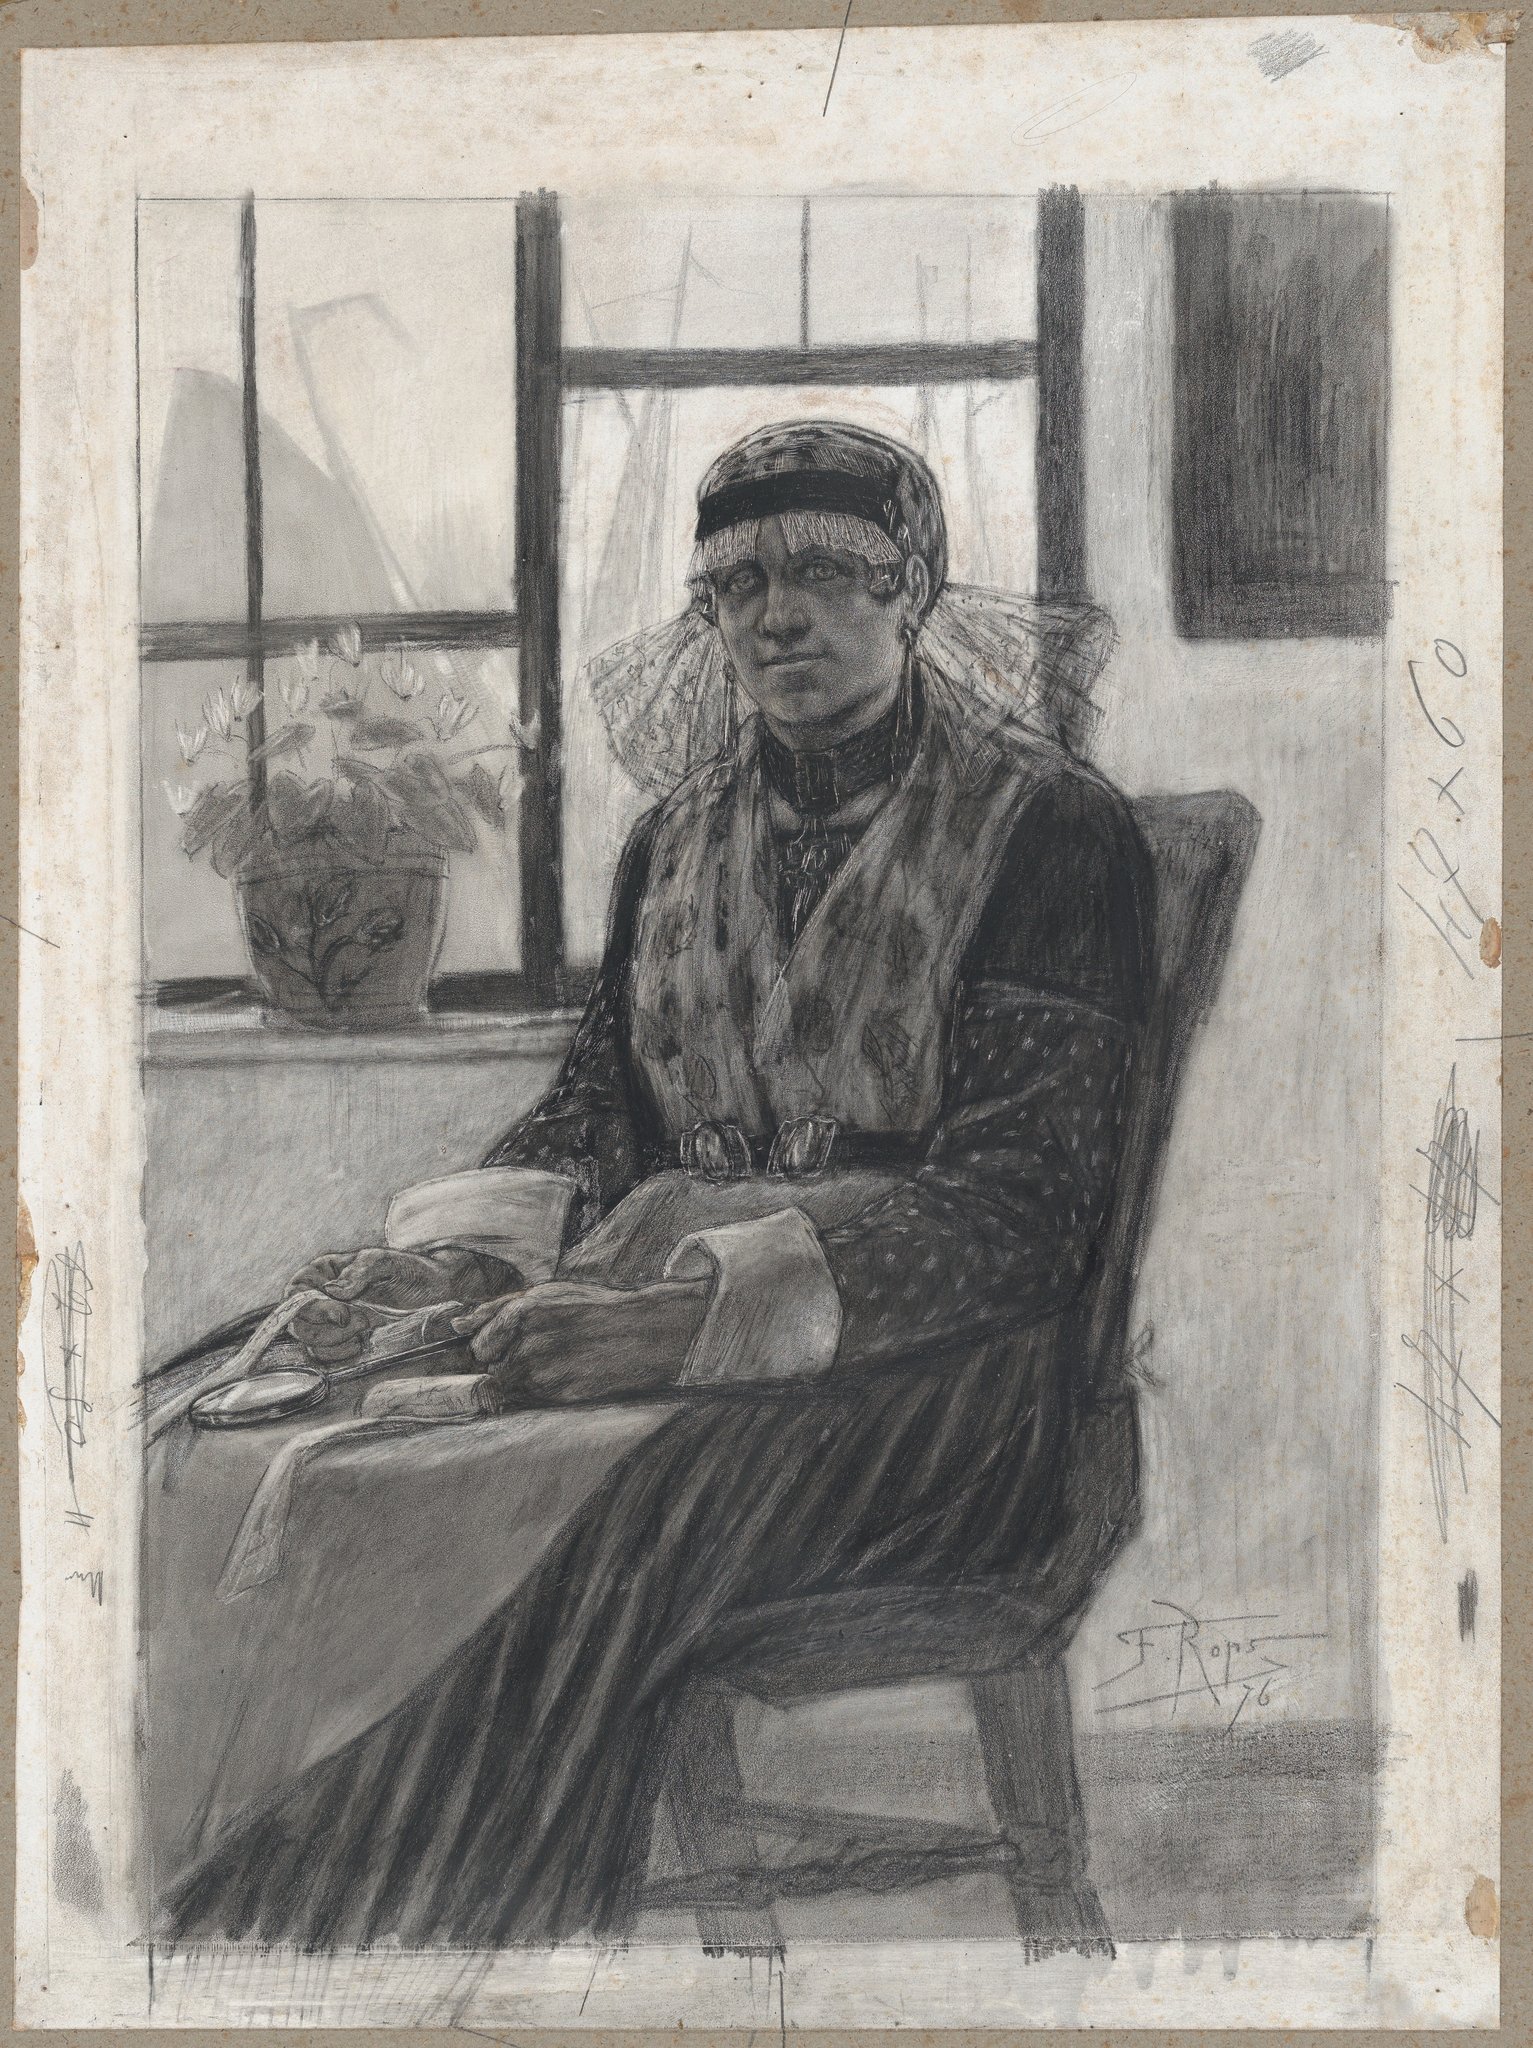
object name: drawing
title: The Lace-Maker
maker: félicien rops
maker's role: artist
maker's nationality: belgian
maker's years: 1833-1898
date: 1876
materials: graphite, gum arabic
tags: women,needlework